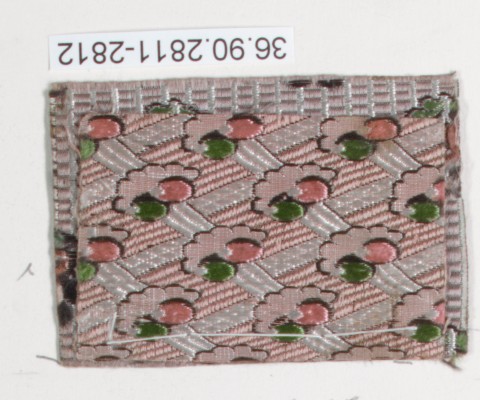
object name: piece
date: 1801-1900